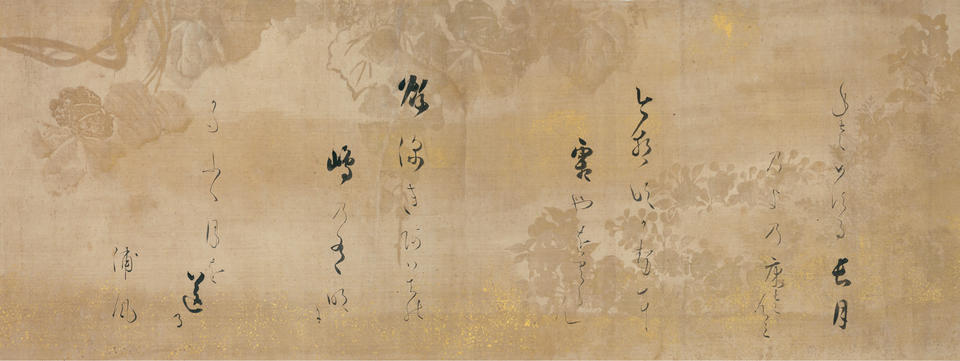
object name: handscroll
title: Twelve Poems from the New Collection of Poems Ancient and Modern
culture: japanese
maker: hon'ami kōetsu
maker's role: artist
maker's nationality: japanese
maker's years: 1558-1637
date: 1620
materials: gold, ink, silk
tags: poetry